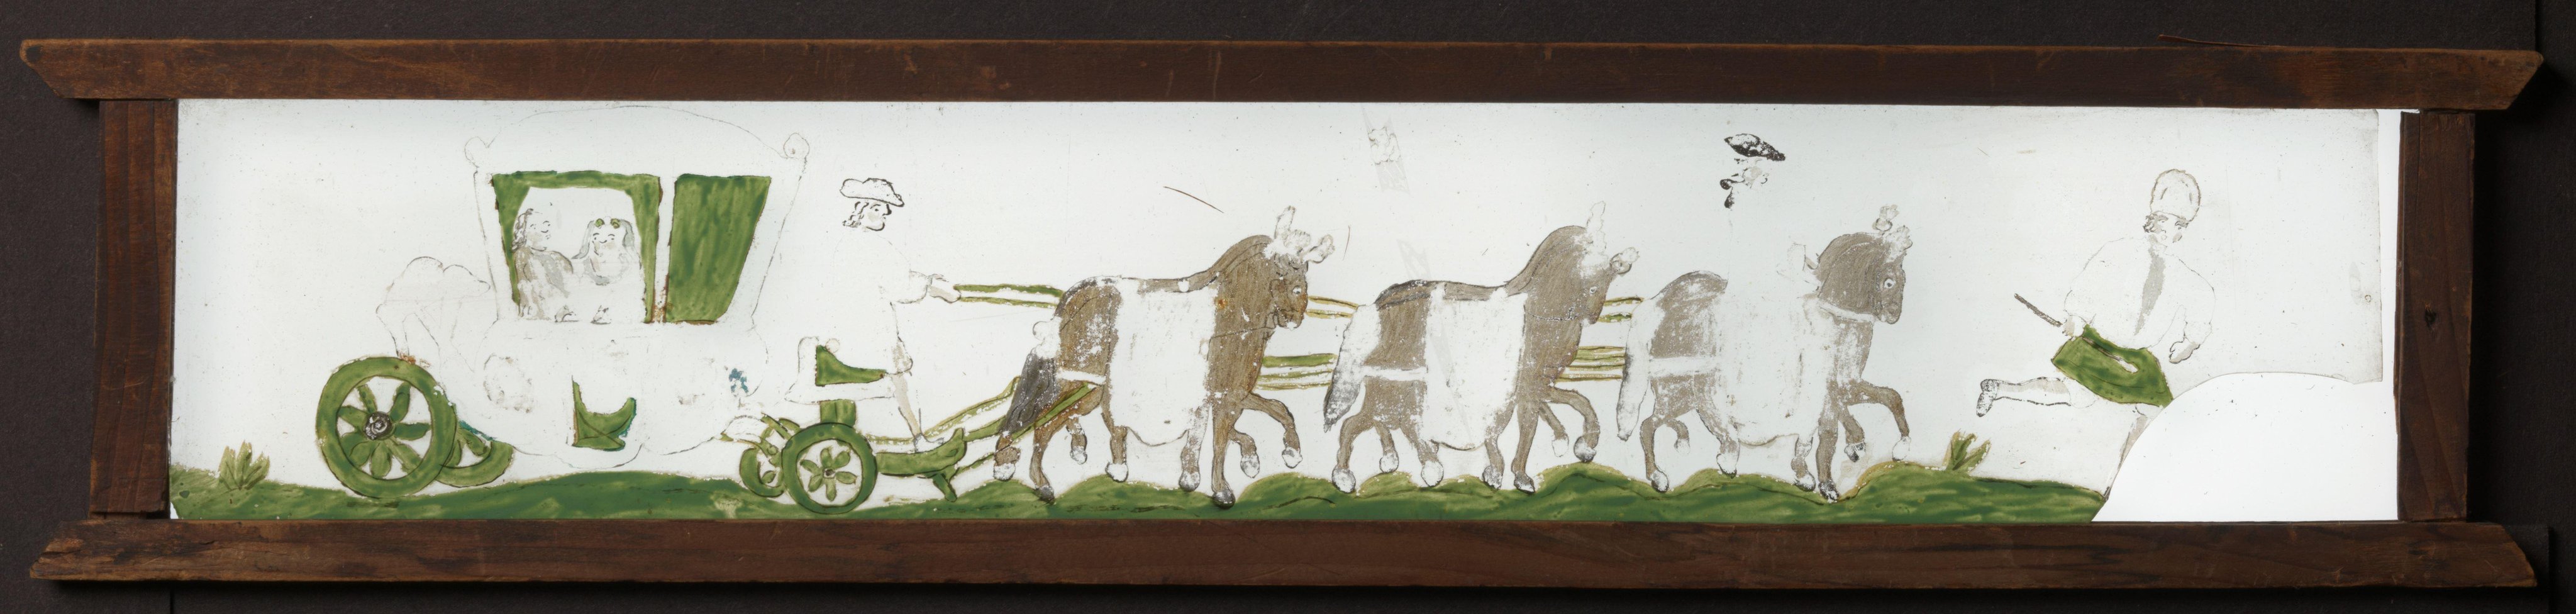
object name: lantern slide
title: Een koets getrokken door paarden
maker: Anonymous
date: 1750-1800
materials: glass, wood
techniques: painted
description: Houten frame met glasplaat, gebruikt voor toverlantaarn. Een koets wordt door zes paarden getrokken. In de koets zitten twee personen. Op de bok zit een man en op het voorste paard ook. Een andere man loopt voor de koets en paarden uit.